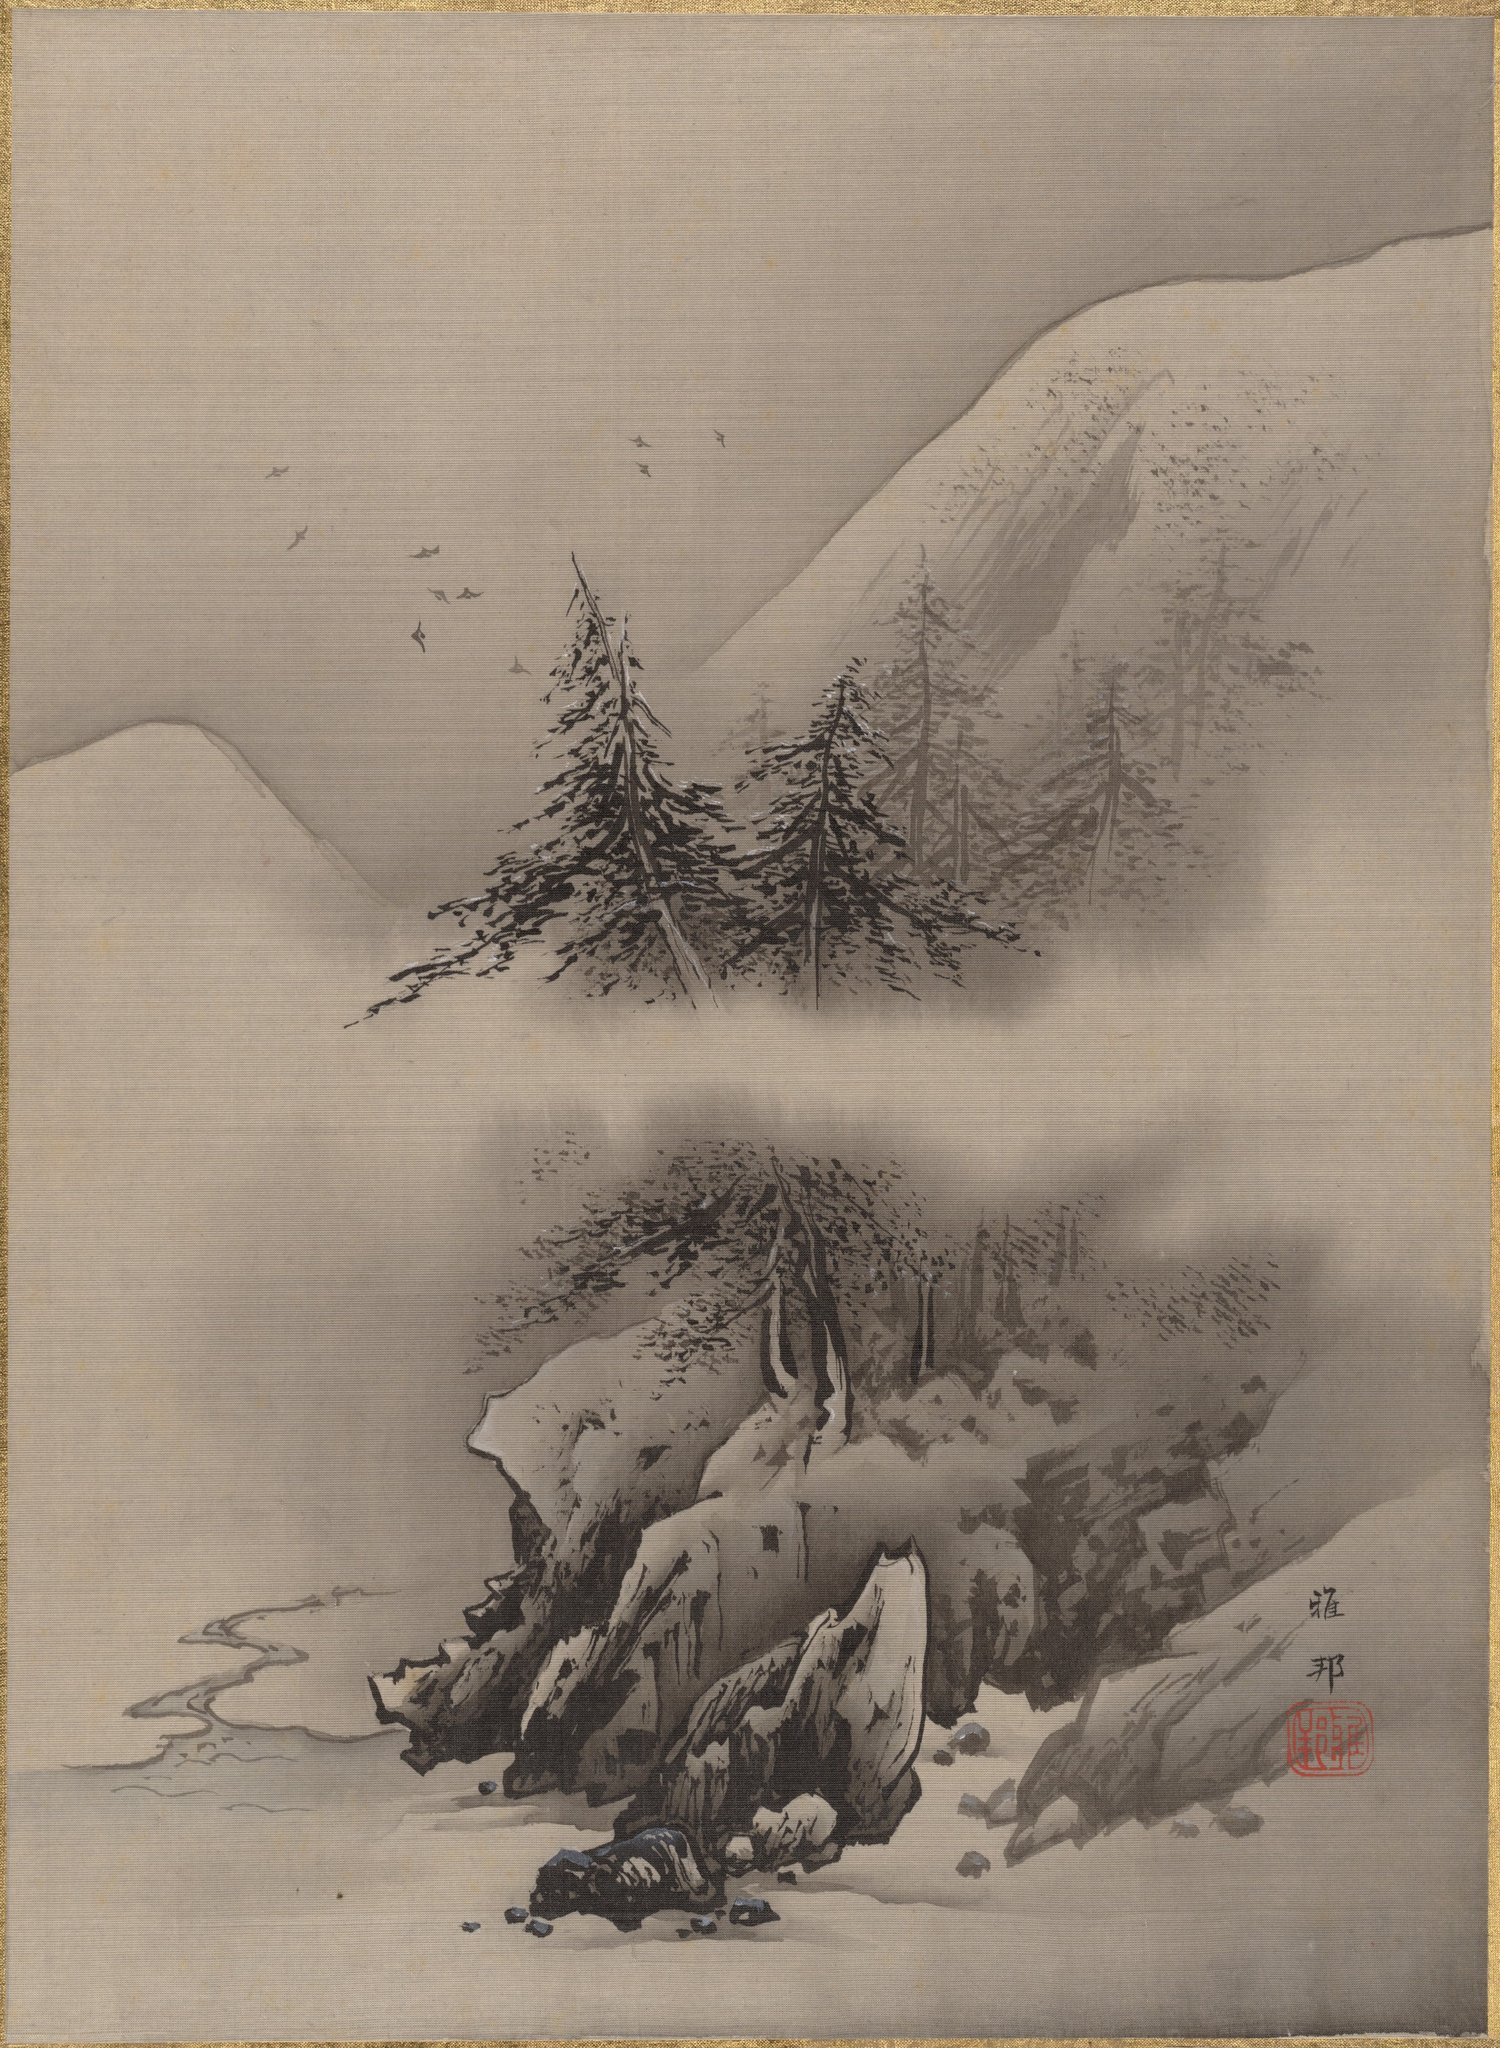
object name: album leaf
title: Snow Landscape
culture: japanese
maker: hashimoto gahō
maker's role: artist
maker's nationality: japanese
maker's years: 1835-1908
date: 1885-1889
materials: ink, silk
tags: landscapes,snow